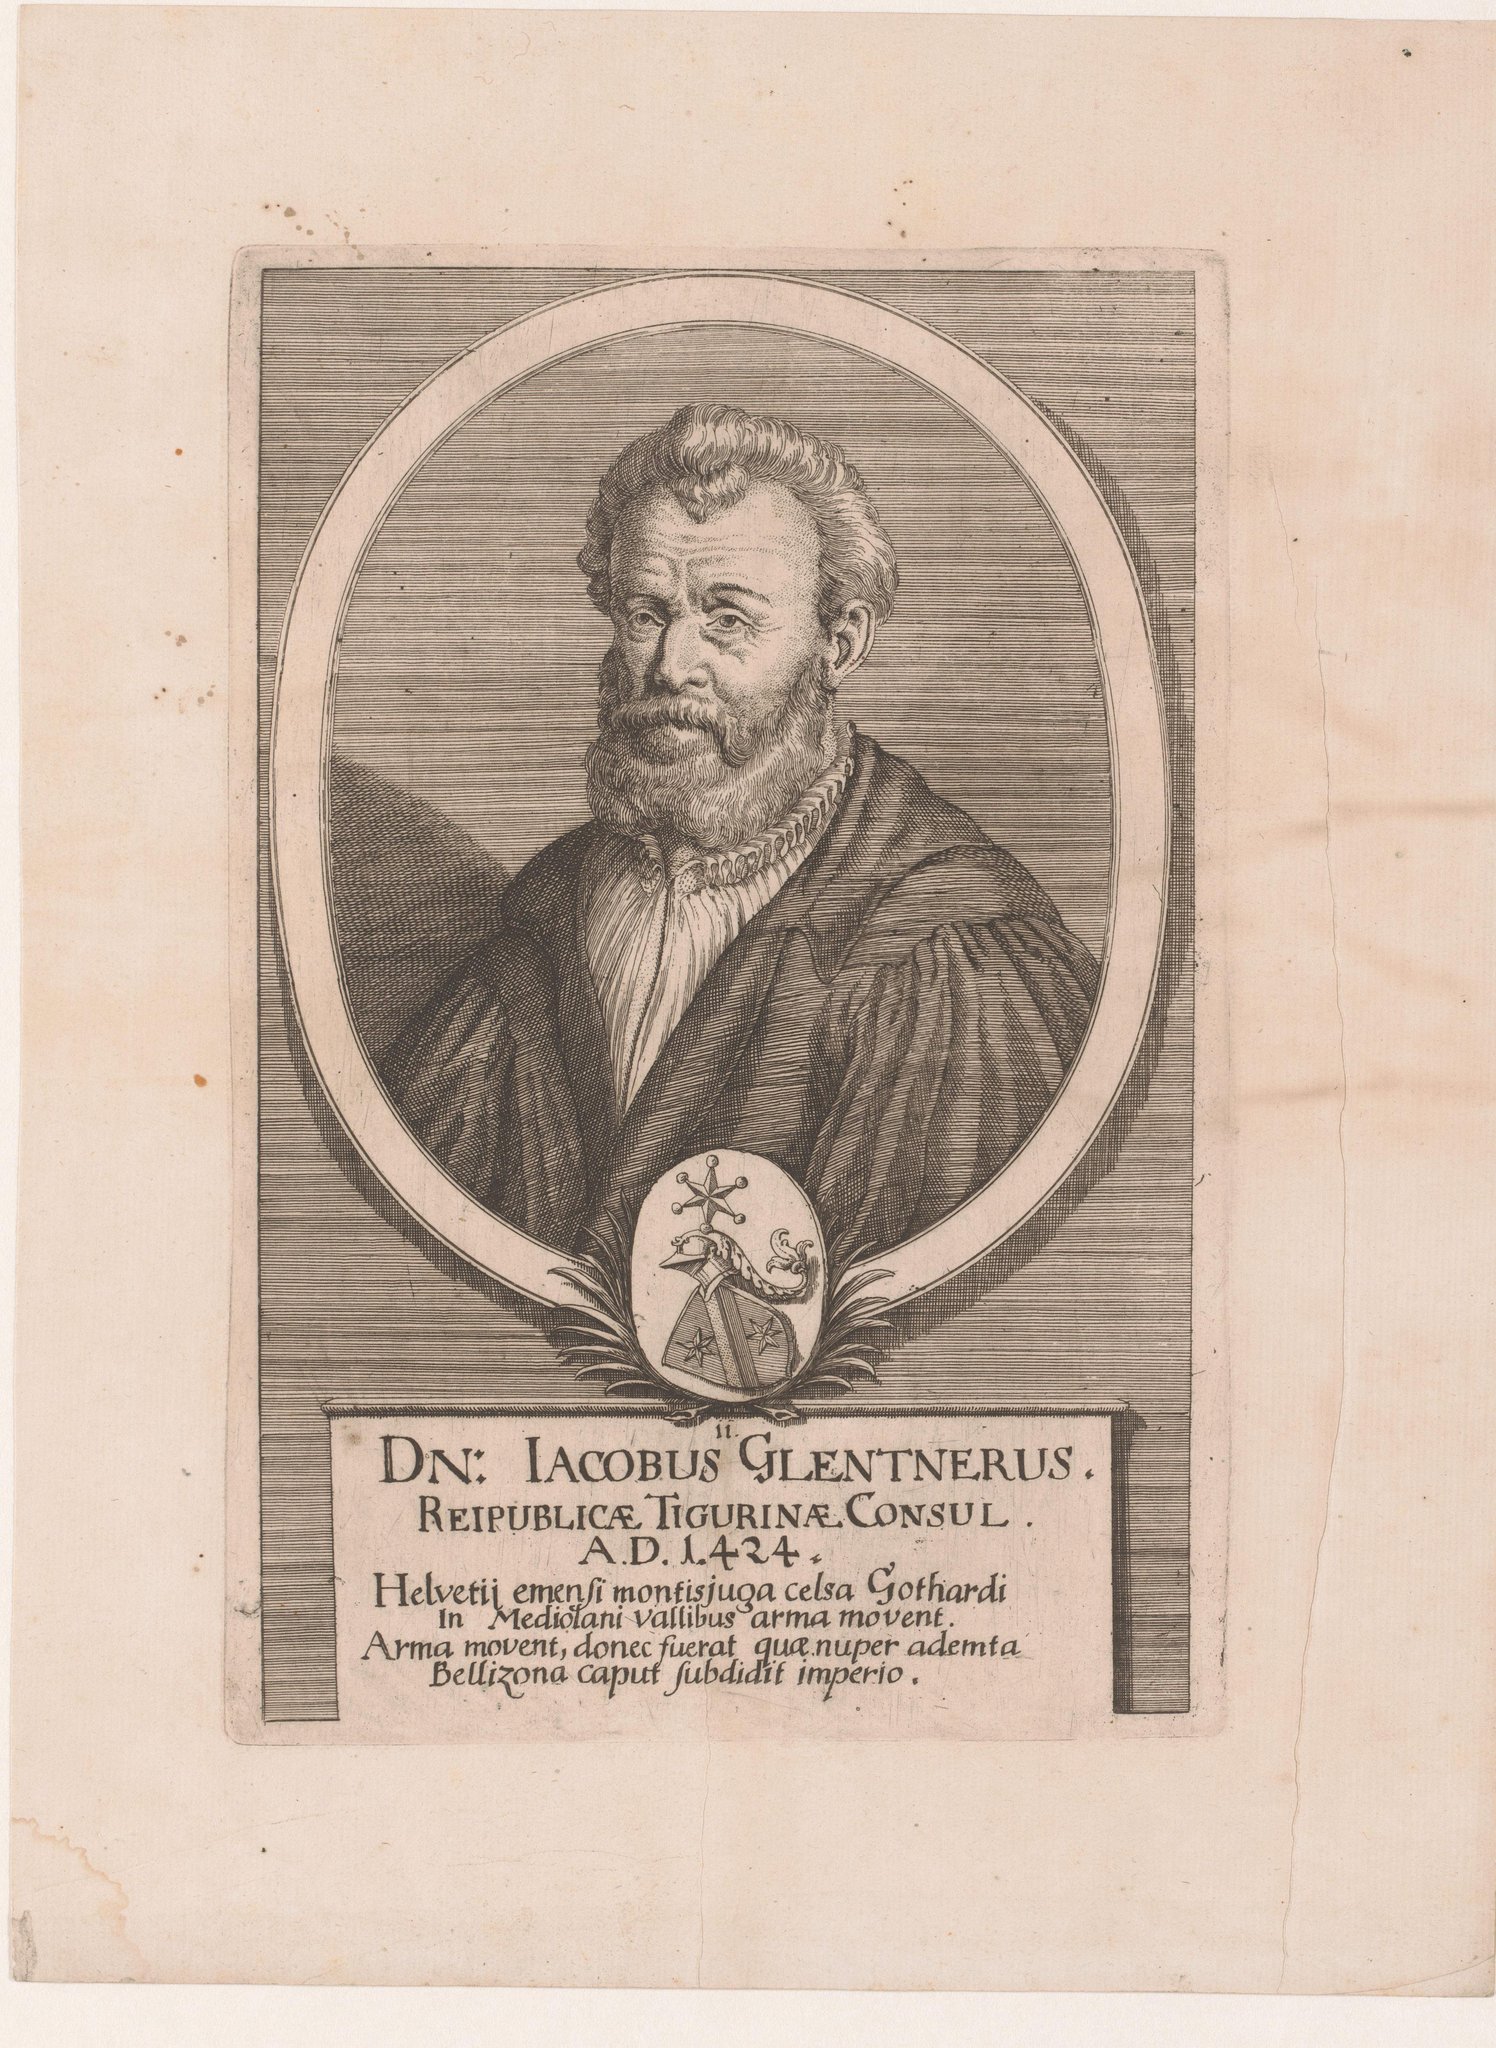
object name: print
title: Portret van Jakob Glentner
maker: johannes meyer (ii)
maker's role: print maker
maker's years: 1655-1712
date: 1665-1712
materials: paper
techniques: engraving, etching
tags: mayor, burgomaster, historical persons, armorial bearing, heraldry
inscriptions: collector's mark: Lugt 2228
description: Onderaan de ovale omlijsting genummerd: 11.